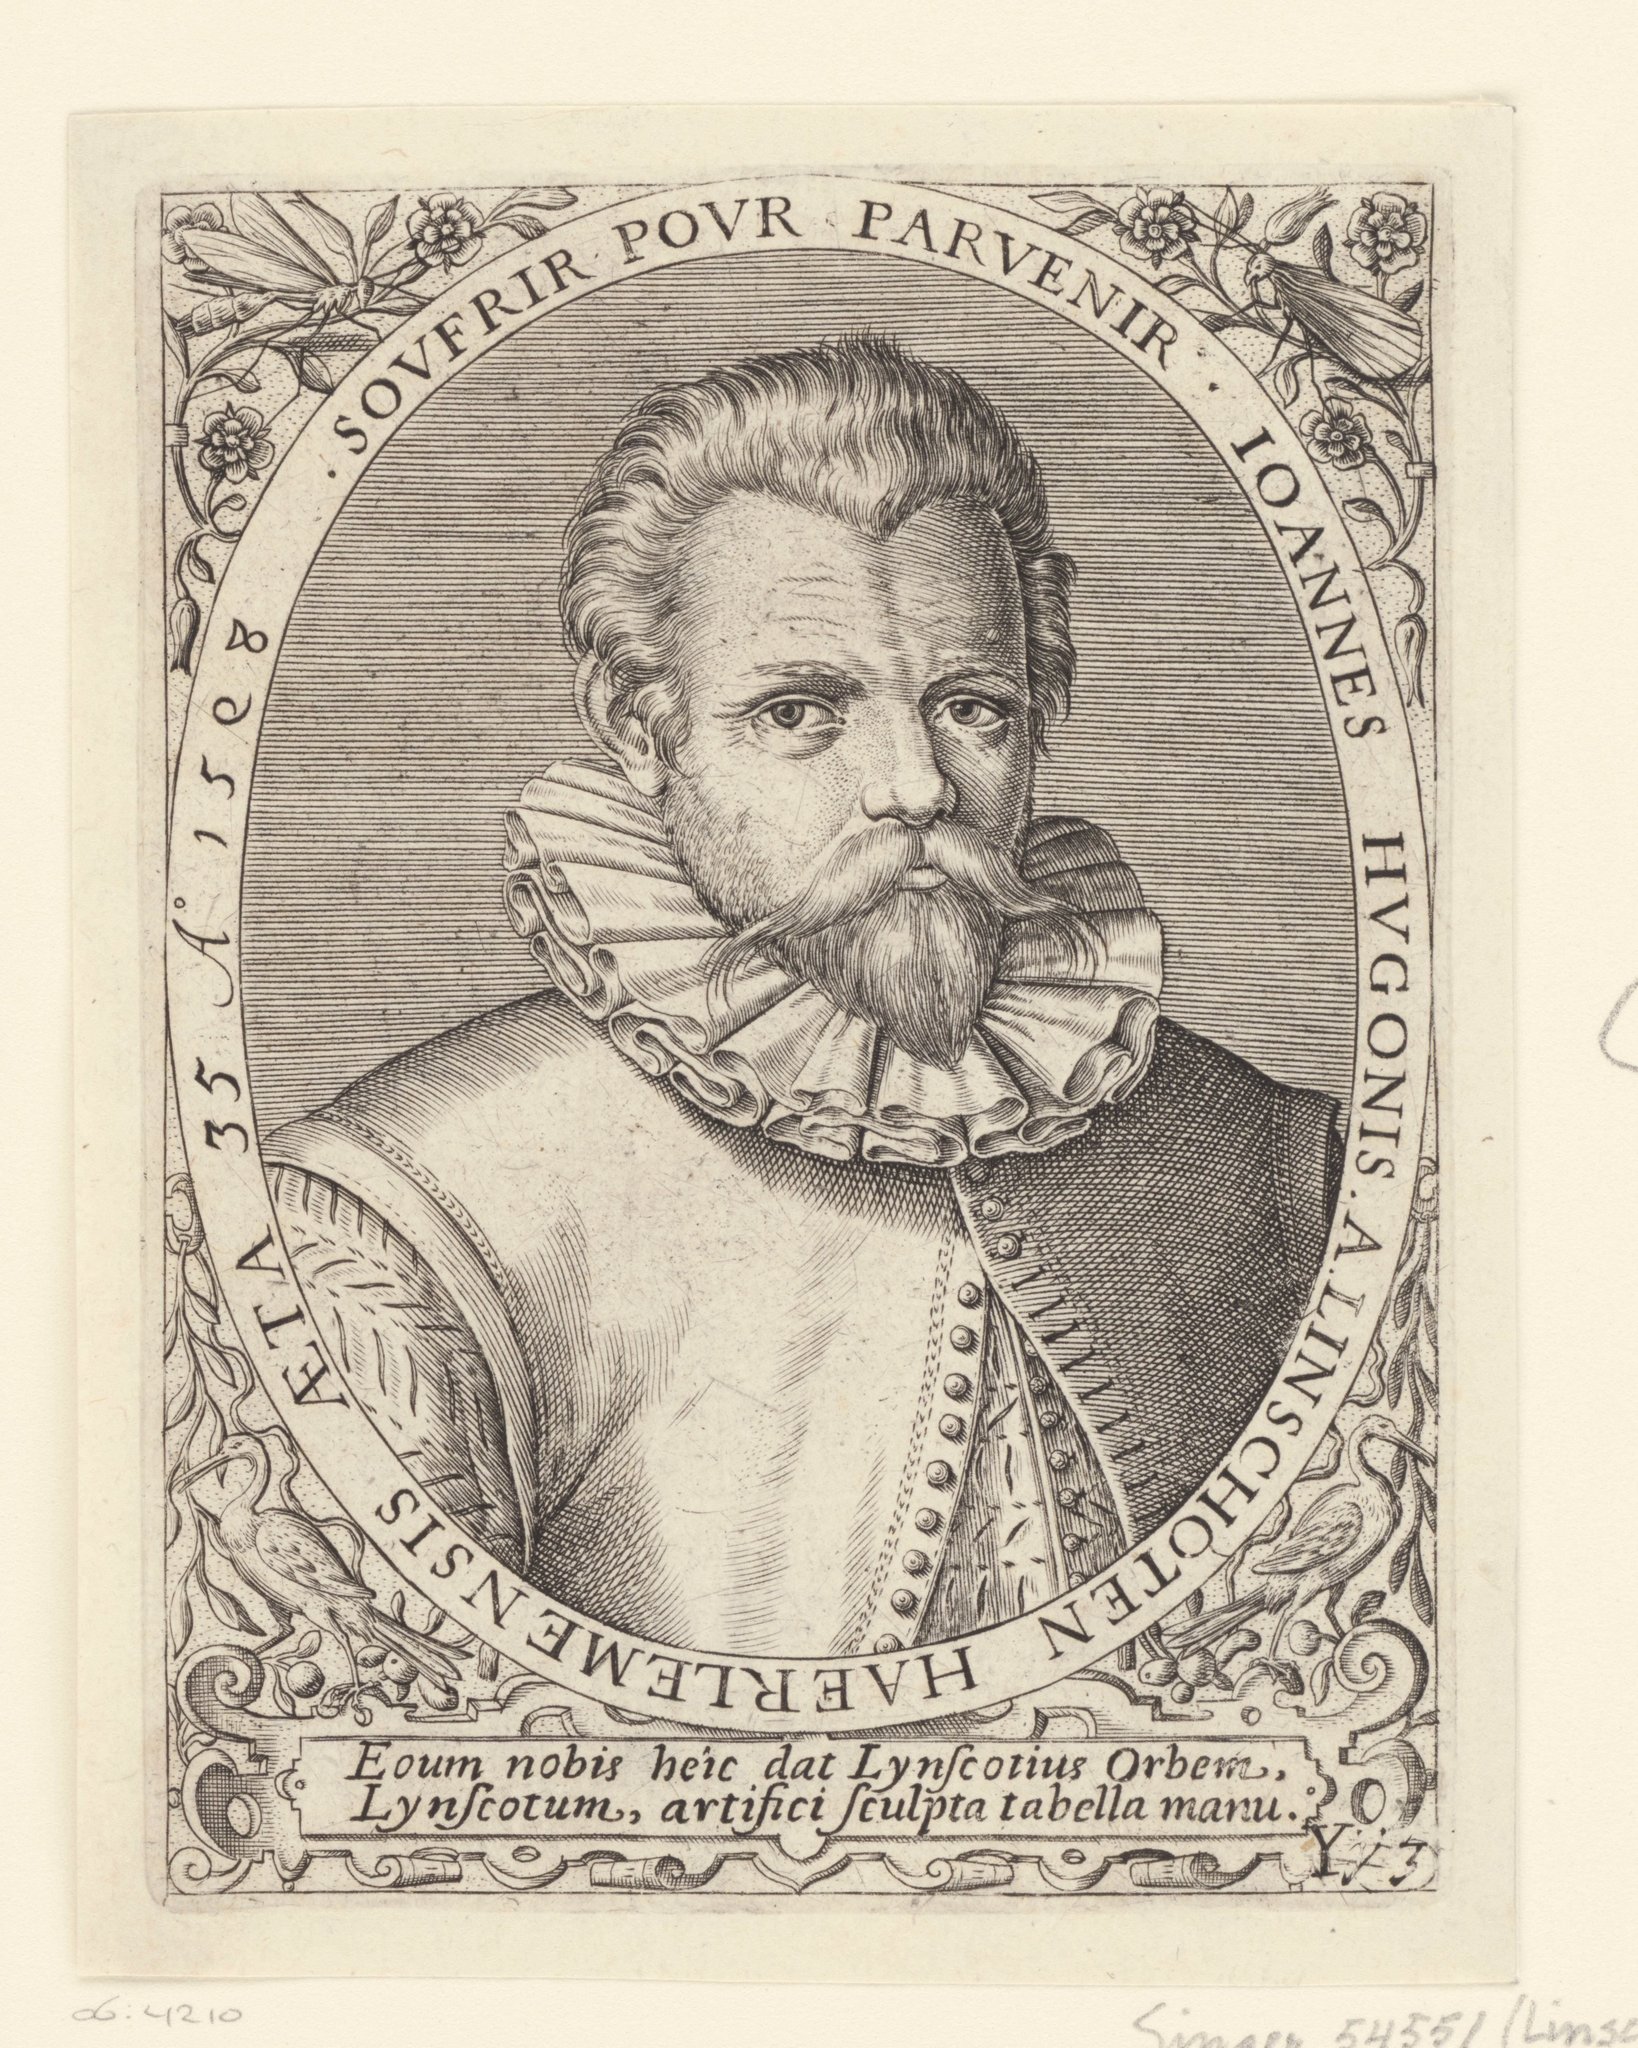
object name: print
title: Portret van Jan Huygen van Linschoten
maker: jean jacques boissard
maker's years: 1528-1598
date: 1669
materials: paper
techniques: engraving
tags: haarlem, jan huygen van linschoten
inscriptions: collector's mark: Lugt 2228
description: Gemaakt voor: J.J. Boissard, Icones virorum illustrium doctrina &c eruditione praestanti um contines. Frankfurt am Main: de Bry, 1597-1599. Opnieuw gebruikt in: J.J.Boissard, Bibliotheca chalcographica, hoc est Virtute et eruditione clarorum Virorum Imagines. Heidelberg: Clemens Ammon, 1669 (te herkennen aan de toegevoegde signatuur in de rechter onderhoek: 2Y3).